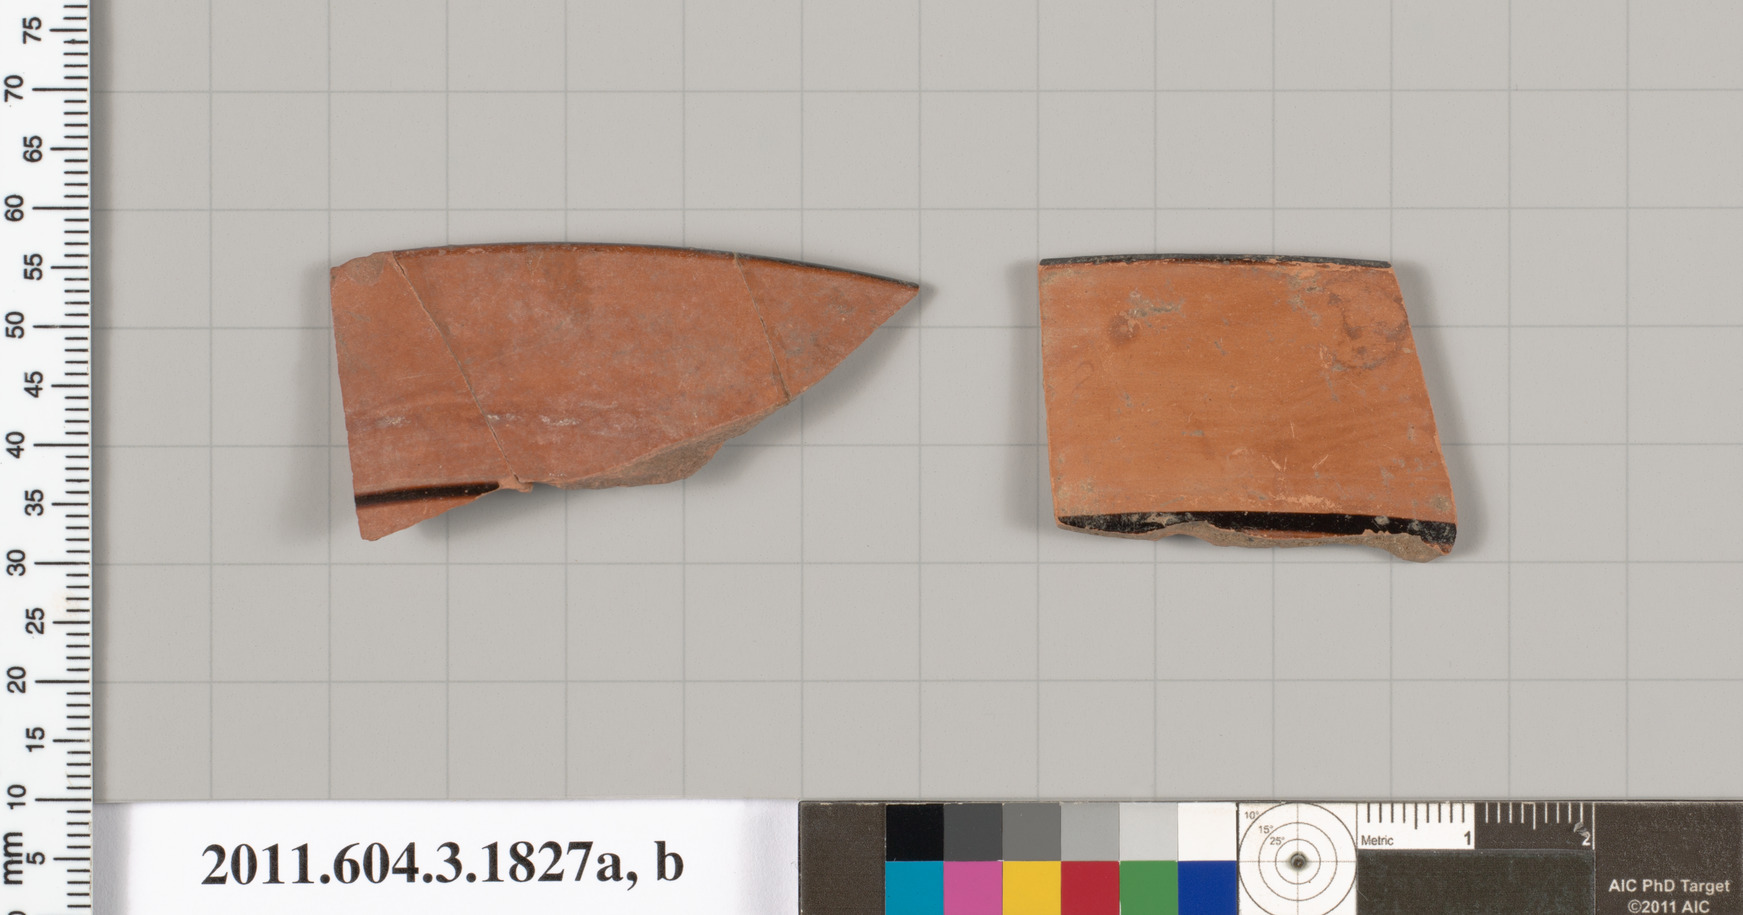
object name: kylix fragment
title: Terracotta rim fragments of kylikes: Lip cup (drinking cup)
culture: greek, attic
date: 560-525 BCE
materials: terracotta